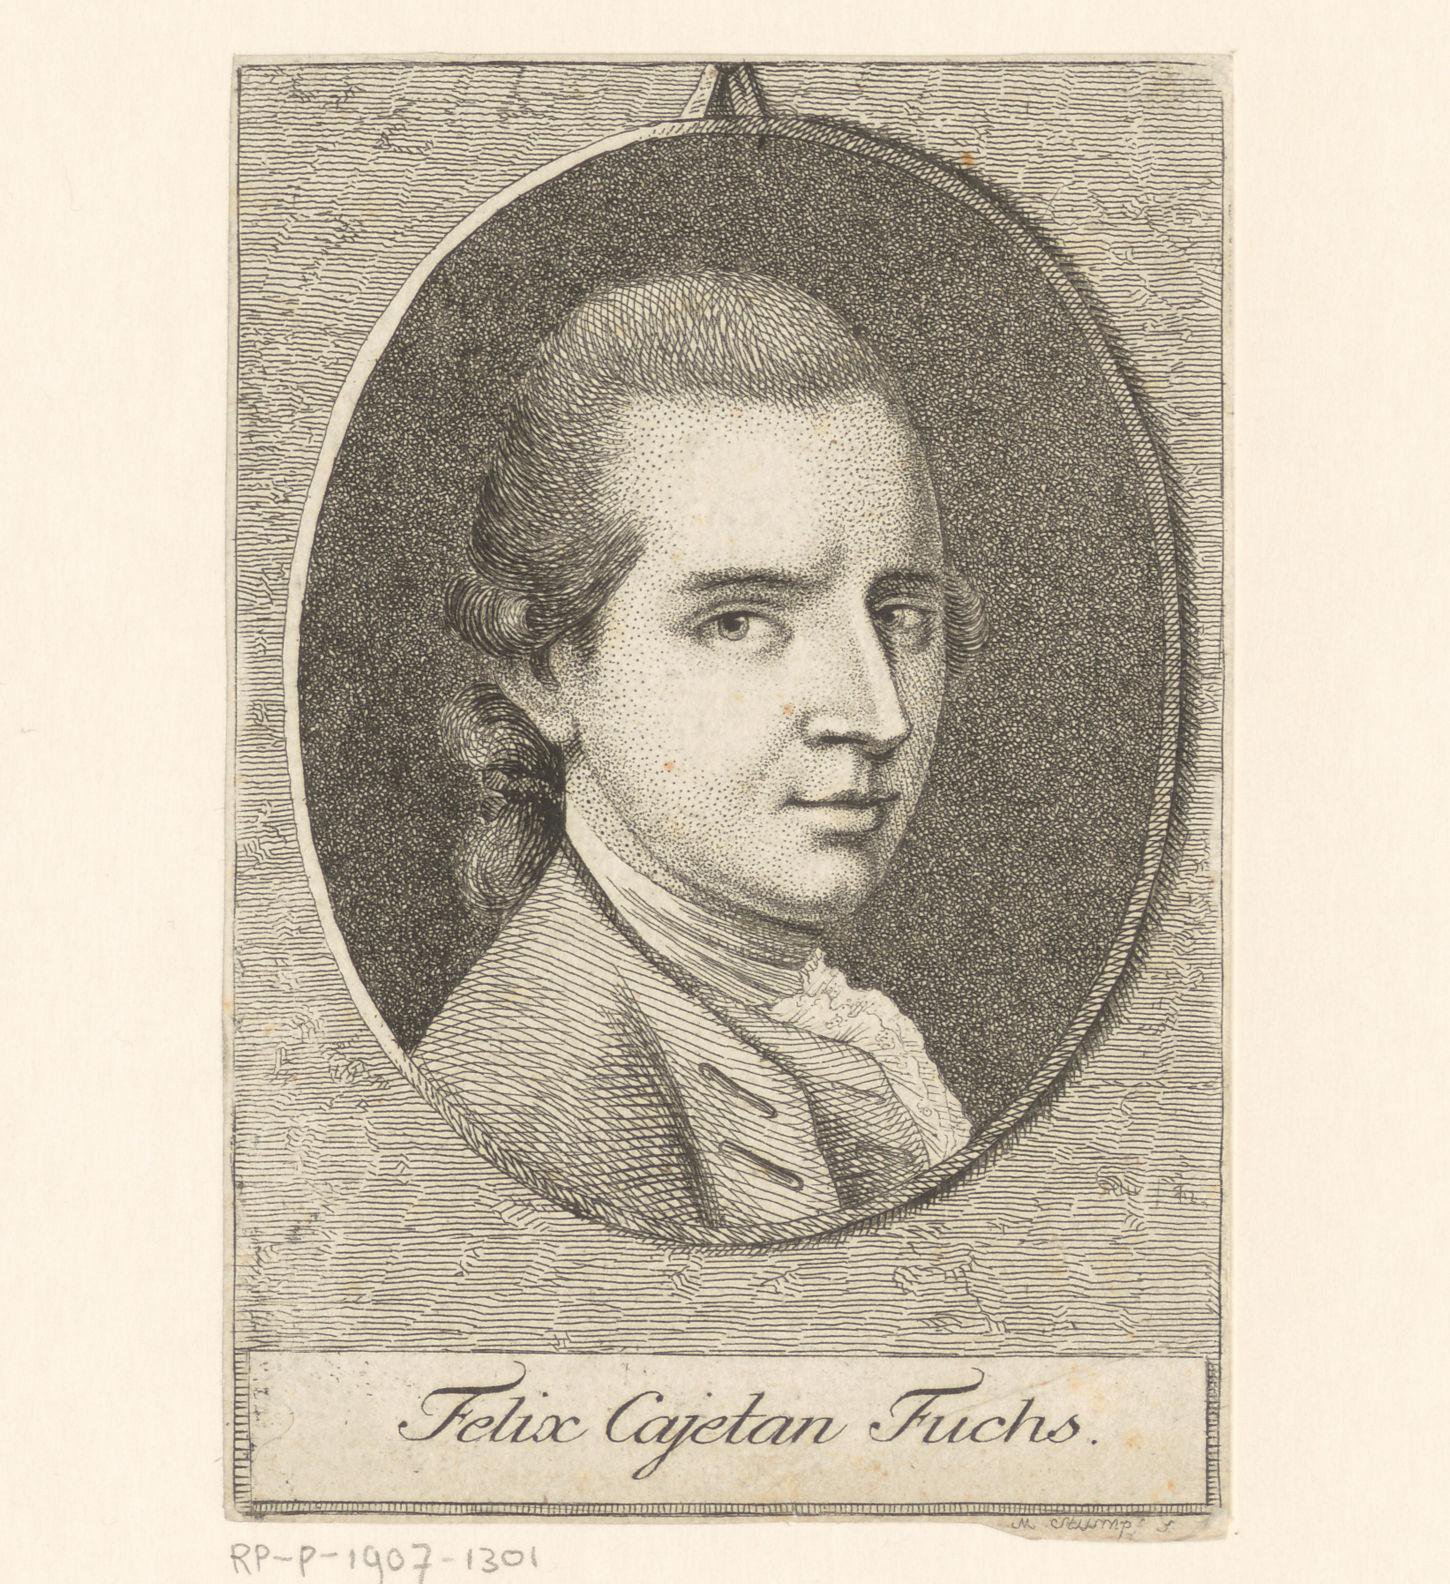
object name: print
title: Portret van Felix Christoph Cajetan Fuchs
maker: matthias stumpf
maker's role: painter, print maker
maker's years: 1755-1806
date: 1770-1806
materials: paper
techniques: etching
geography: zurich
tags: historical persons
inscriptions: collector's mark: Lugt 2228